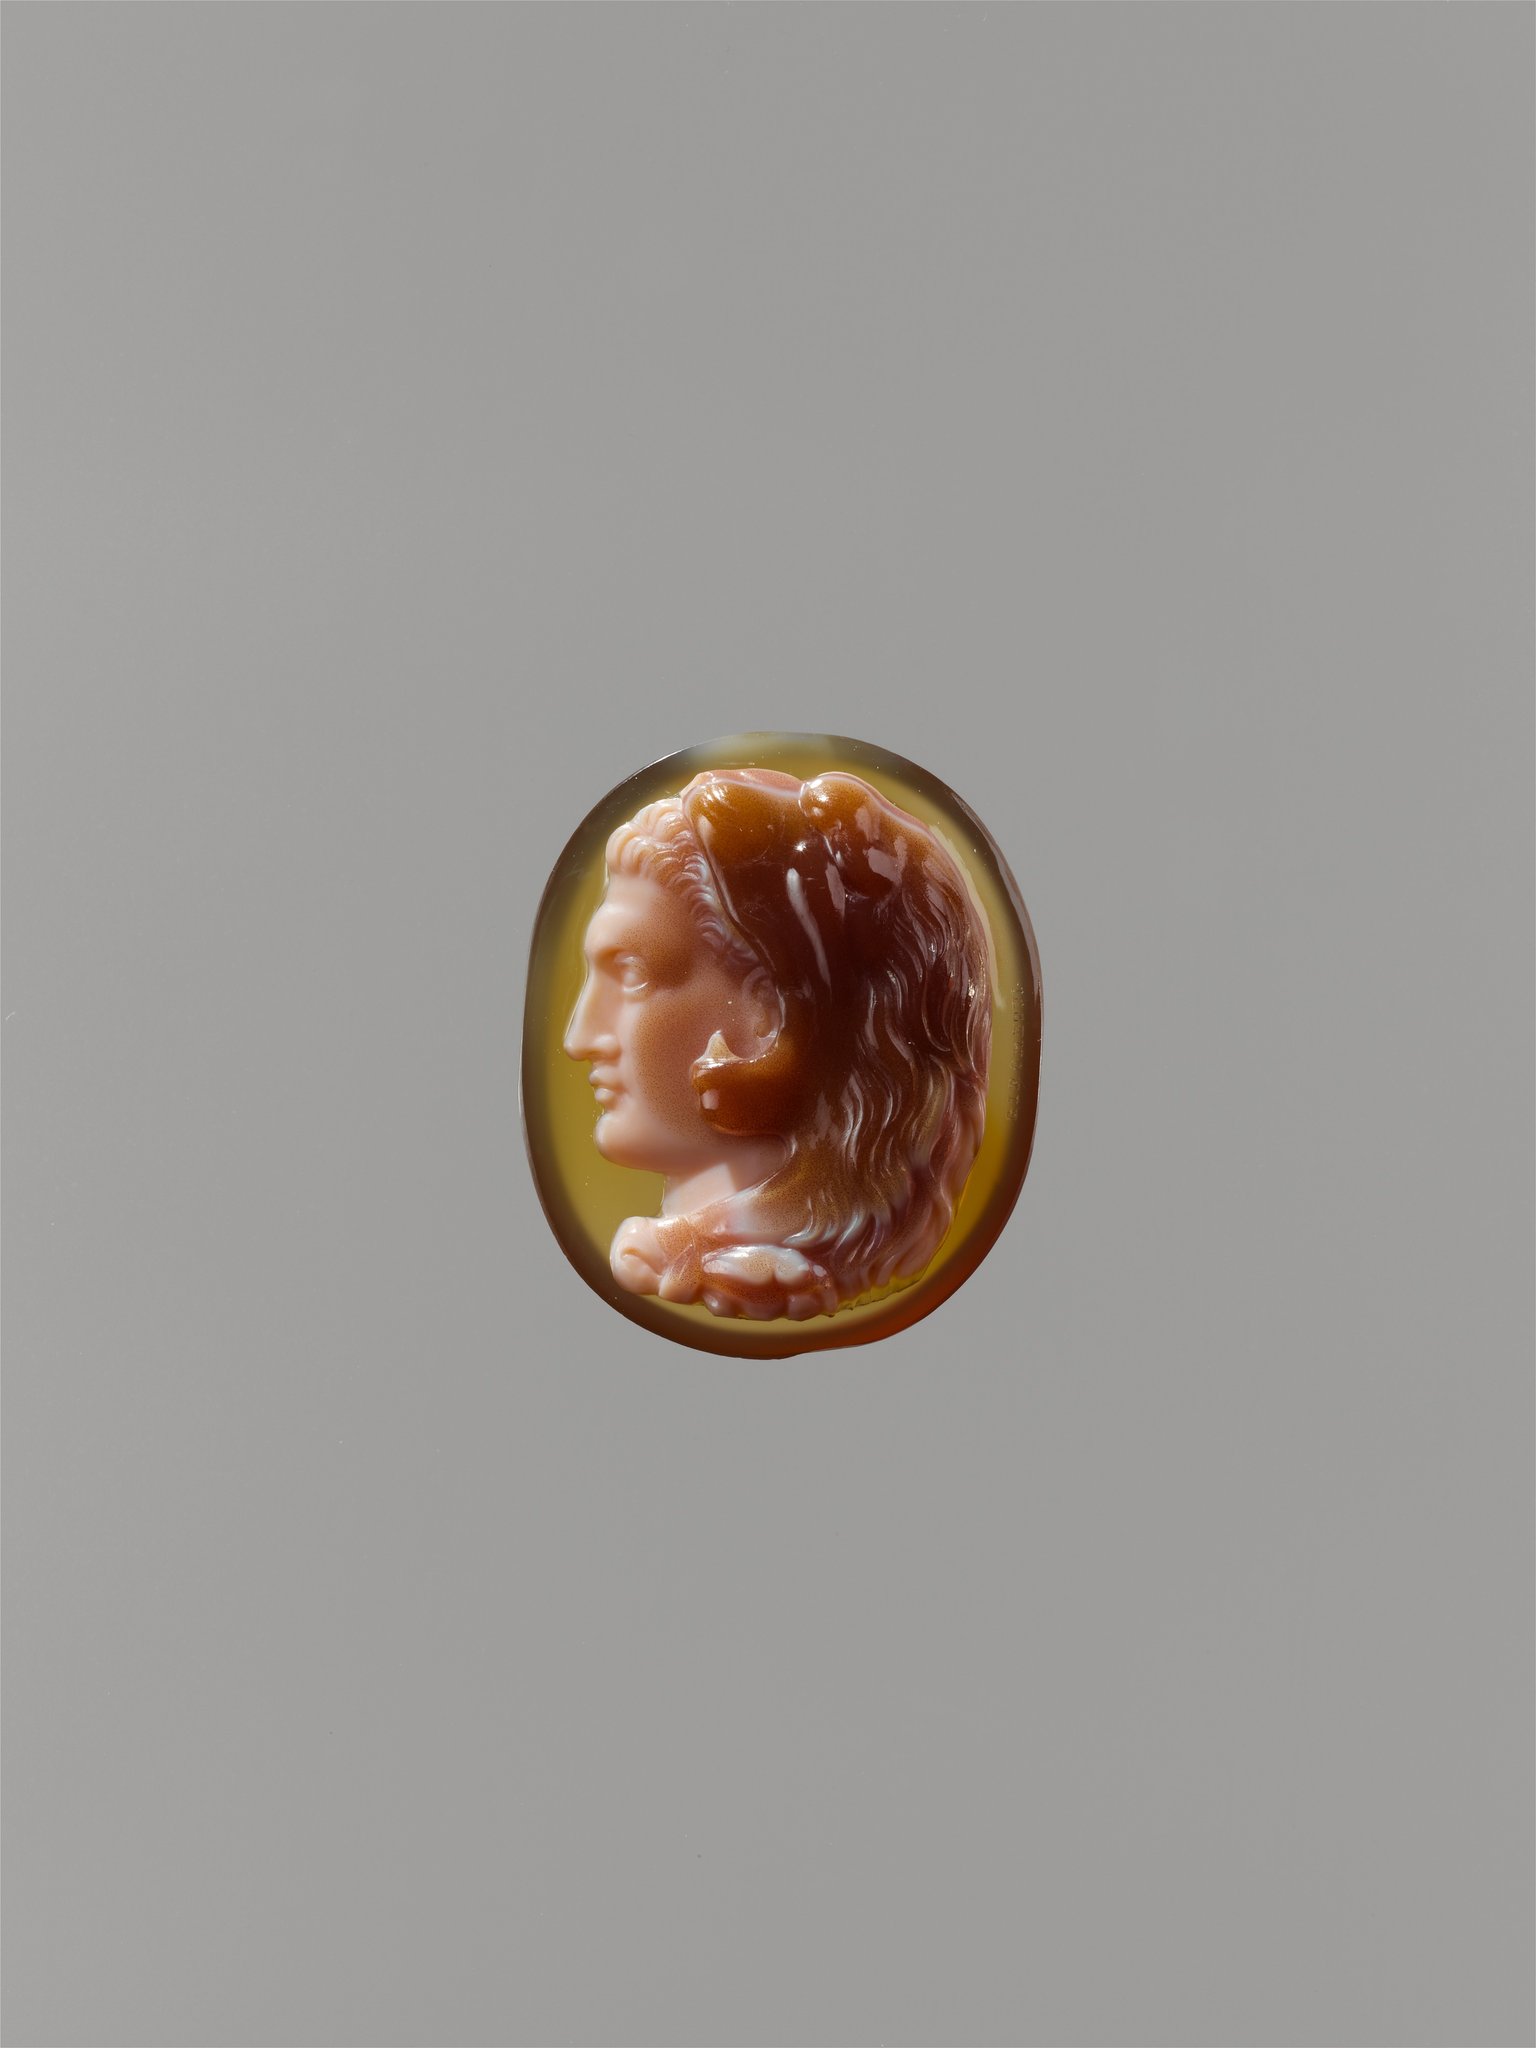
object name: cameo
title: Head of Hercules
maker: giuseppe girometti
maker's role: artist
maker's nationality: italian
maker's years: 1780-1851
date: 1826-1850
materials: gemstone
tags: heads,hercules